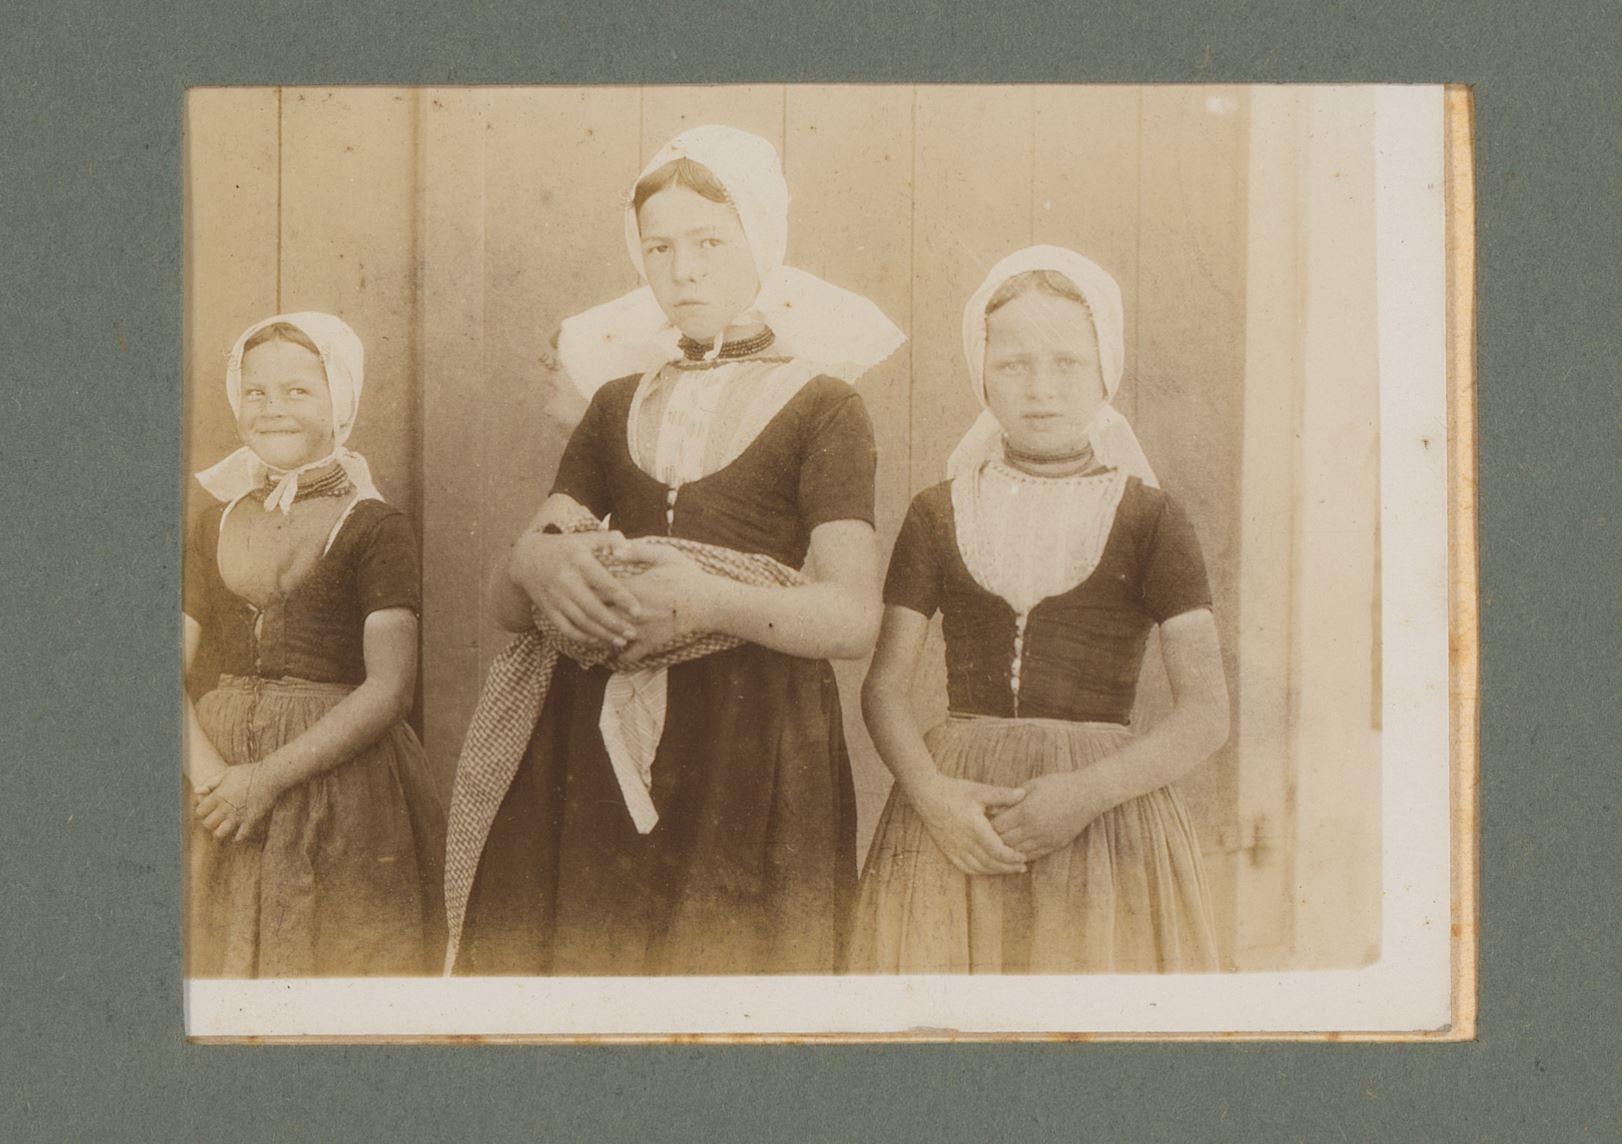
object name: photograph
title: Portret van drie meisjes in klederdracht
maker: george hidderley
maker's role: fotograaf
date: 1920-1940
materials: photographic support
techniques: gelatin silver print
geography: netherlands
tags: girl (child between toddler and youth) (+ three persons), historical persons, folk costume, regional costume